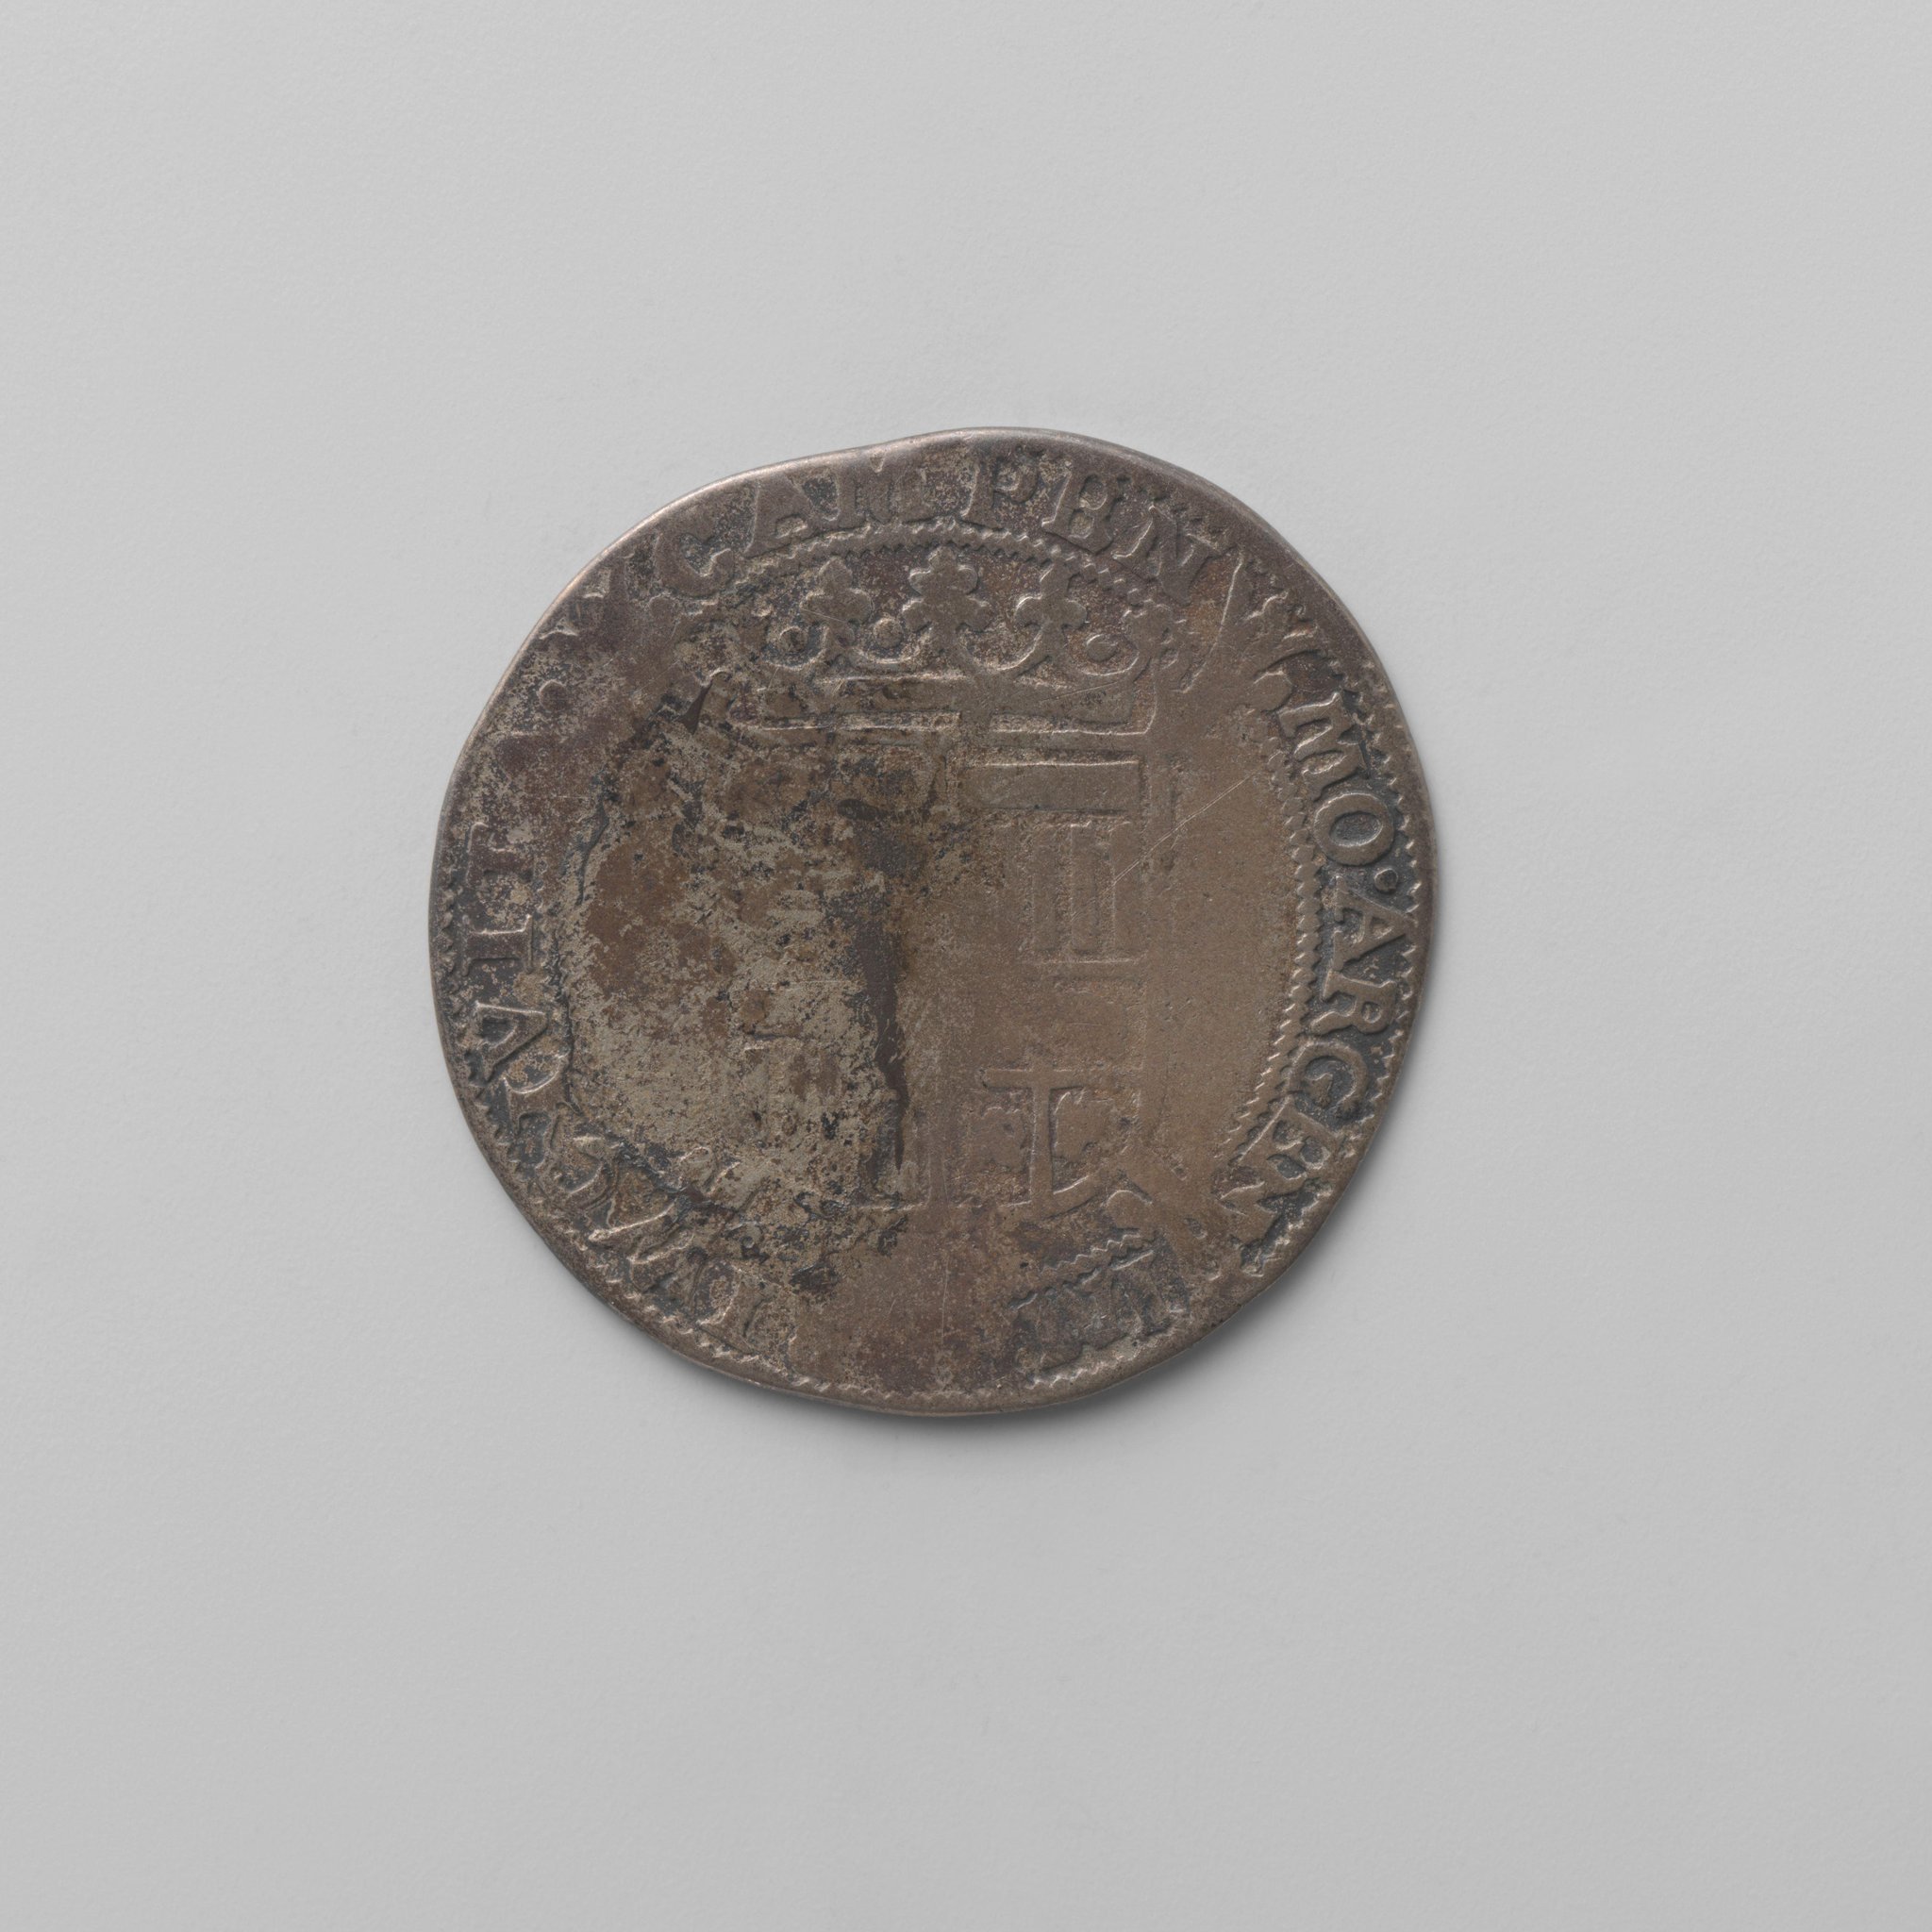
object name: coin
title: Kampen, arendsschelling met naam van keizer Ruddolf II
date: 1590-1610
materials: silver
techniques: striking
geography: kampen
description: Zilveren munt. Voorzijde: gekroond vereenvoudigd Spaans wapenschild. Keerzijde: gekroonde dubbelkoppige adelaar.